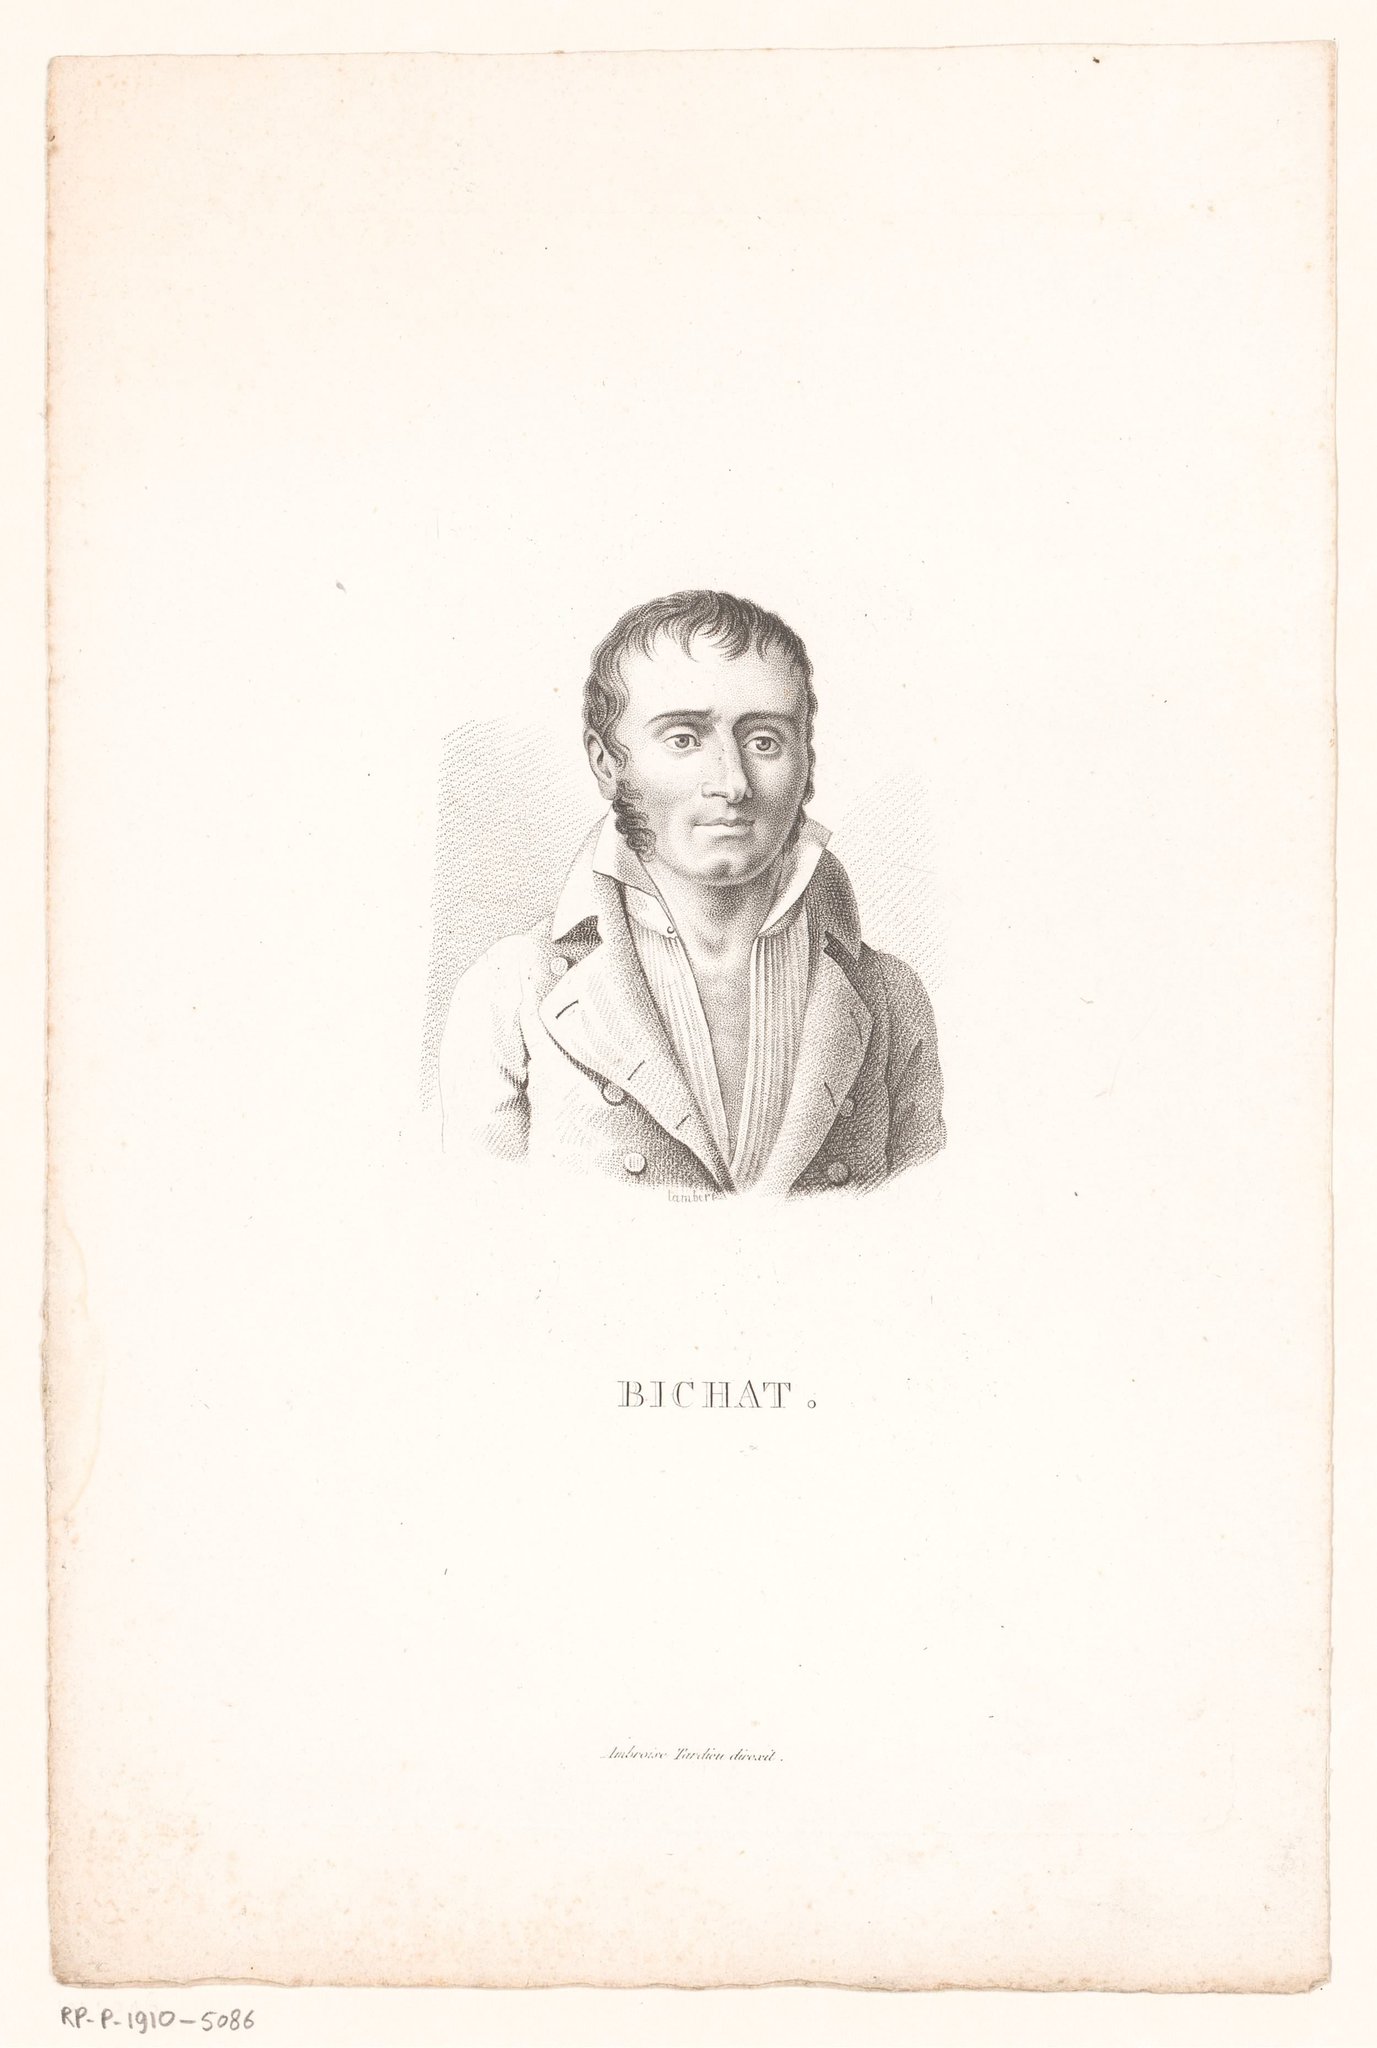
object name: print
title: Portret van Xavier Bichat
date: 1818-1832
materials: paper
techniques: engraving, roulette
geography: paris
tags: paris, scholar, philosopher, historical persons, physician, doctor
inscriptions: collector's mark: Lugt 2228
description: Mogelijk prent uit: Journal complémentaire du Dictionnaire des sciences médicales. Parijs: Panckoucke, Charles Louis Fleury, 1818-1832.